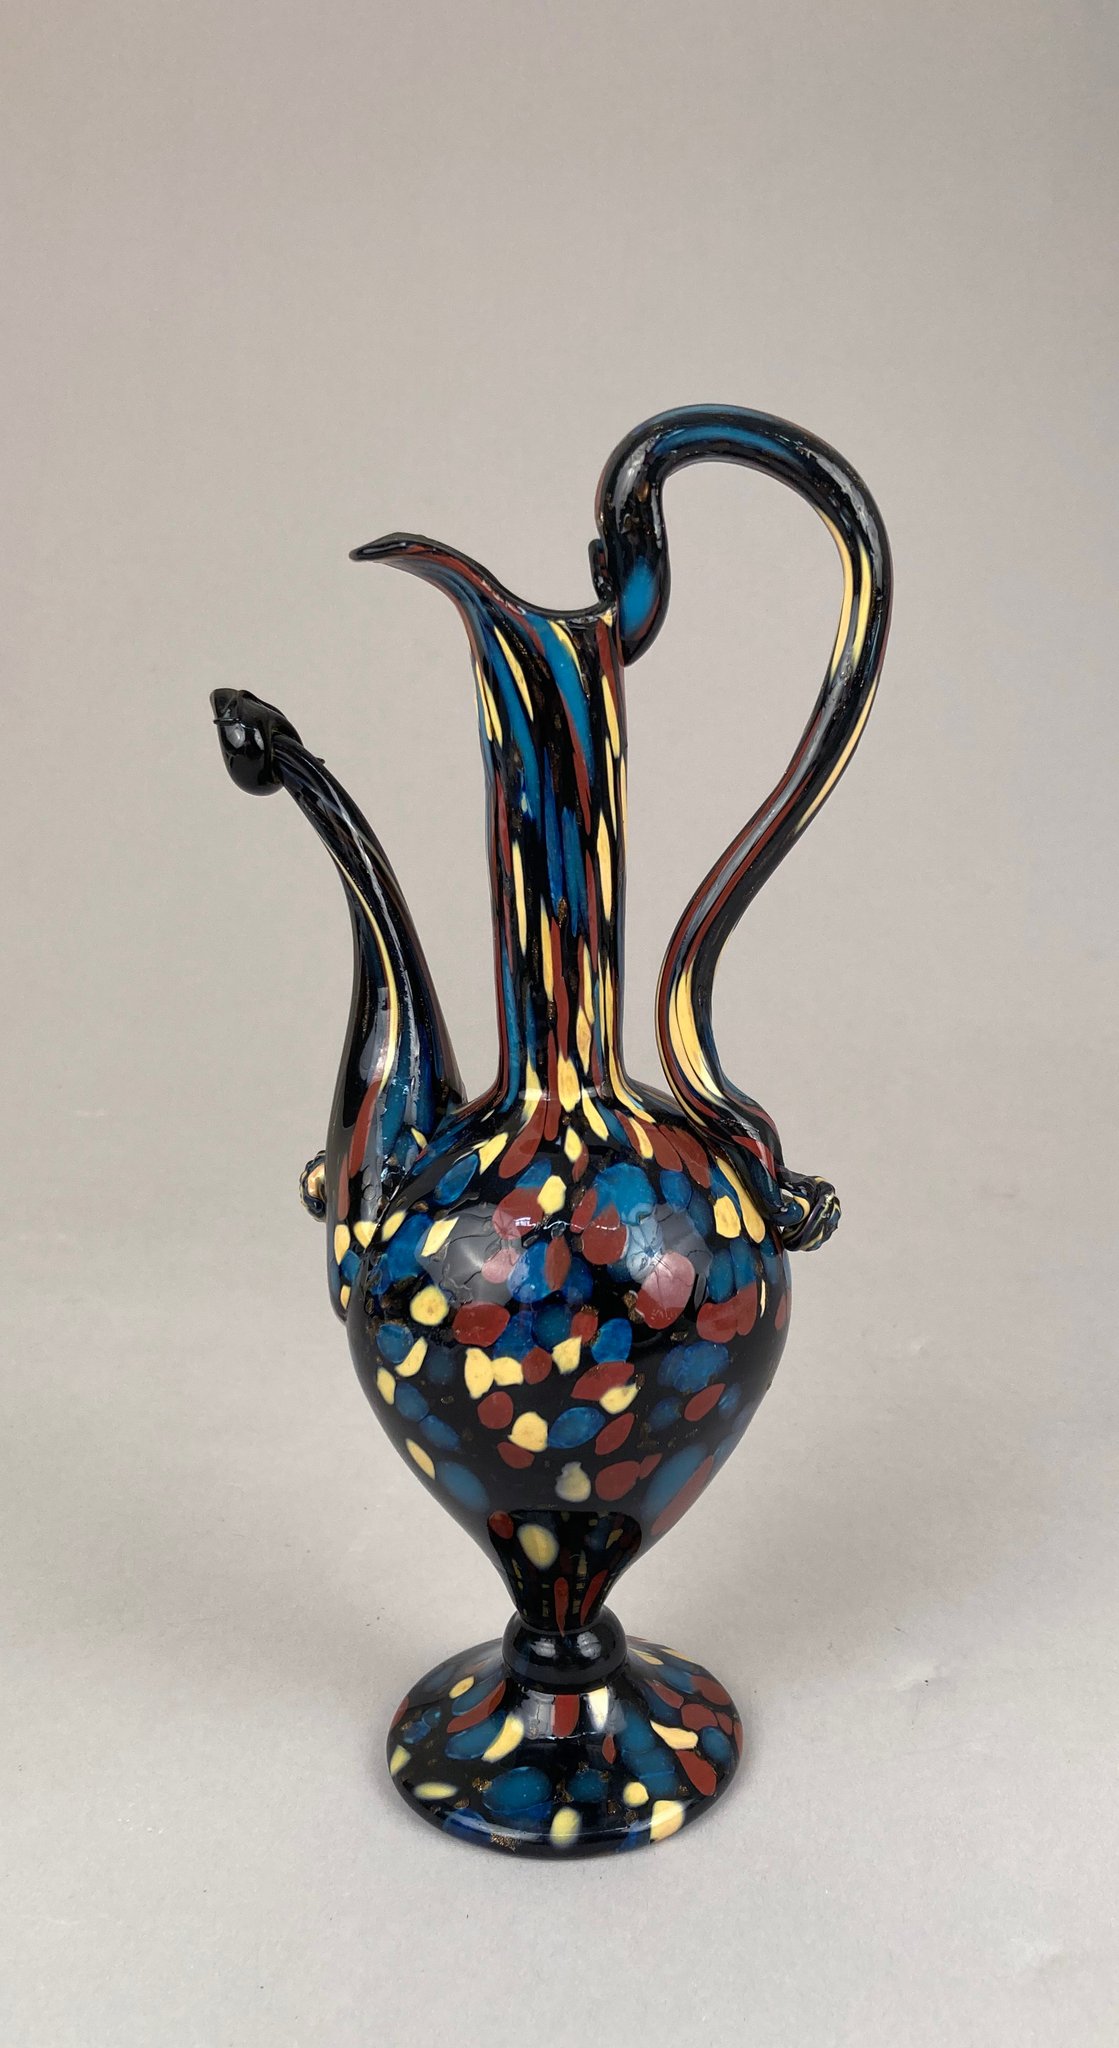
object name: ewer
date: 1810-1830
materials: glass